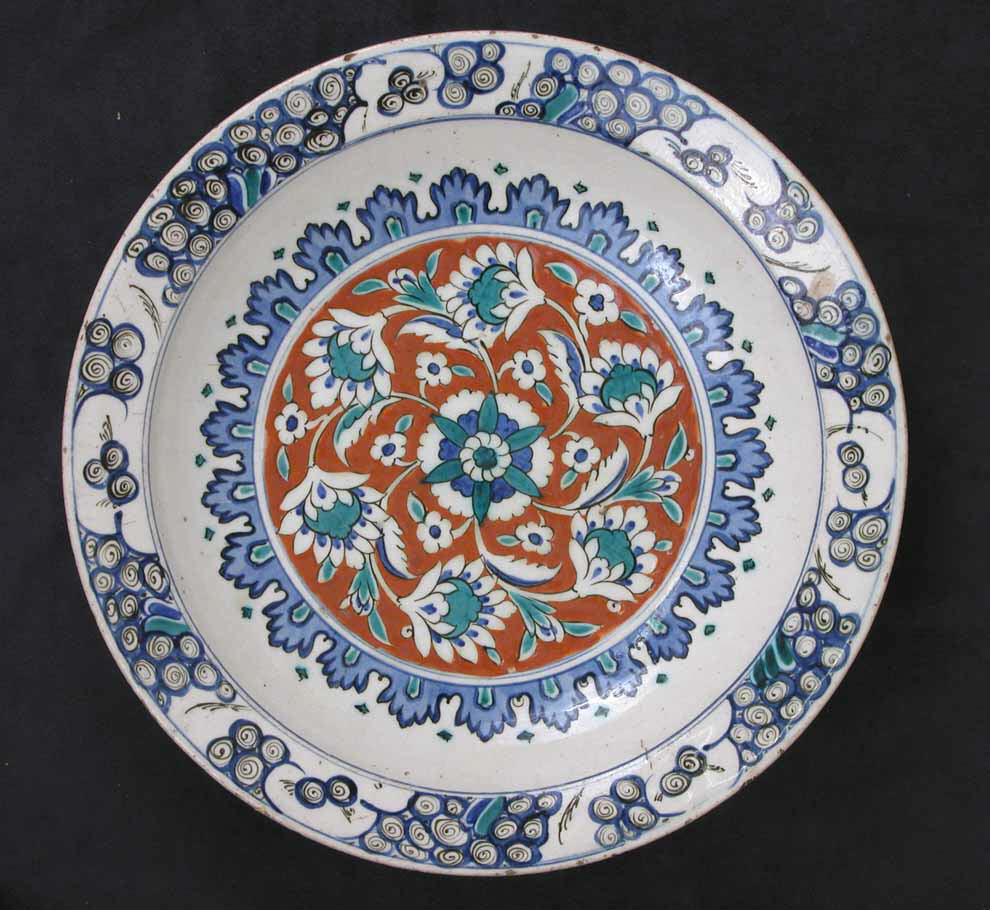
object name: dish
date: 1576-1600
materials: glaze, stonepaste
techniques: painting, polychrome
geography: turkey